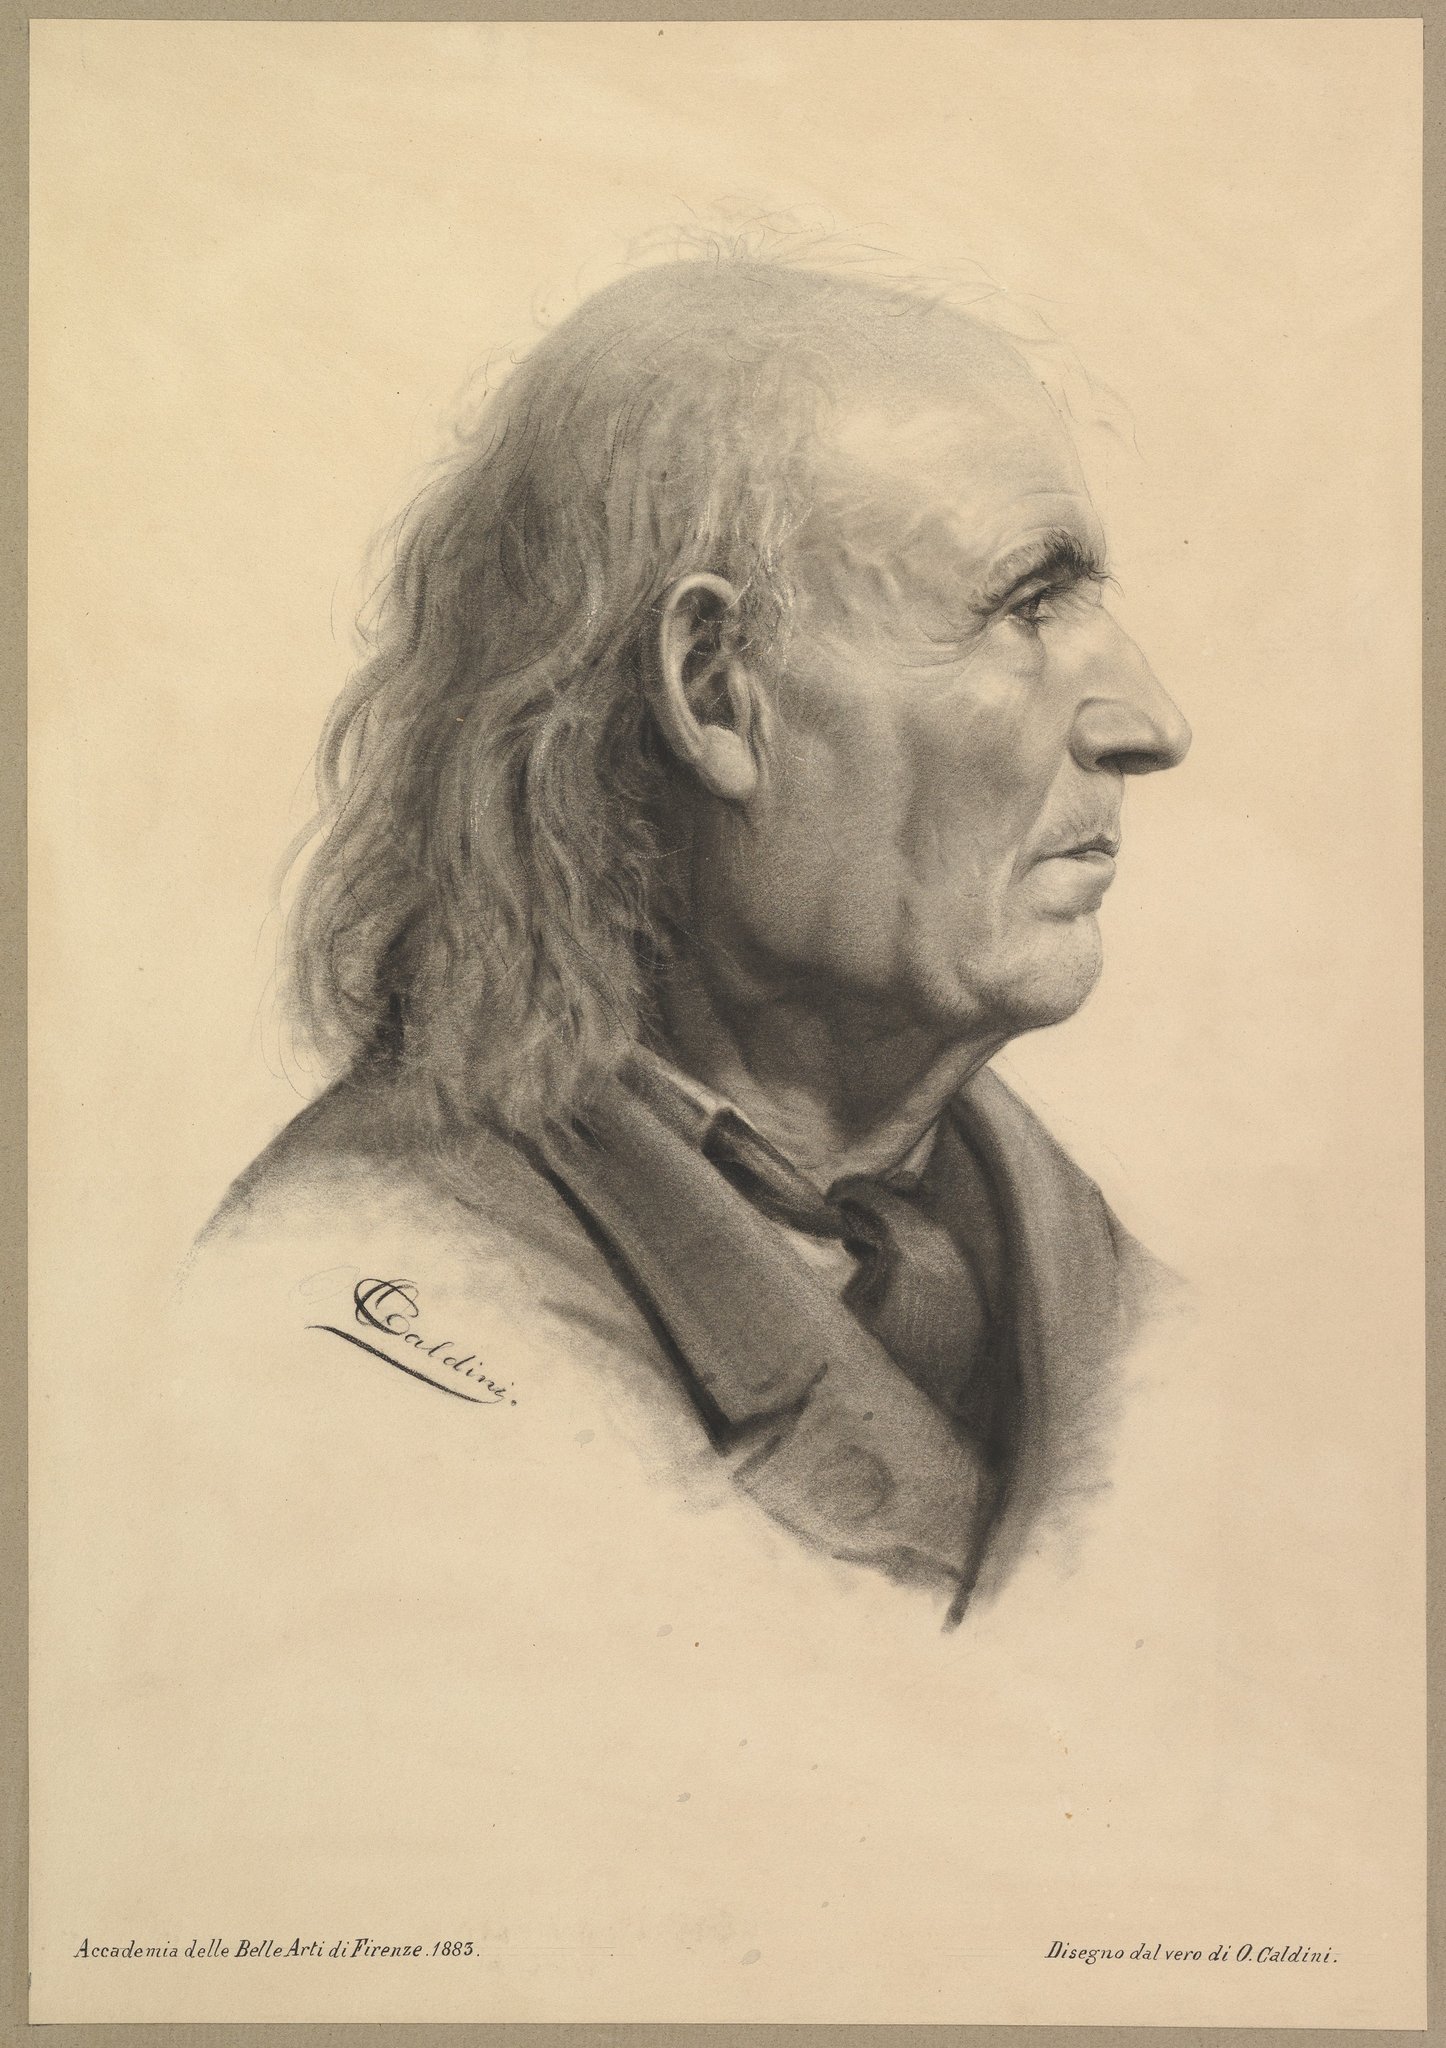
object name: drawing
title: Portrait Head of a Man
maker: oresto caldini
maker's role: artist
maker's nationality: italian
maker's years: 19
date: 1800-1900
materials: charcoal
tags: heads,men,profiles